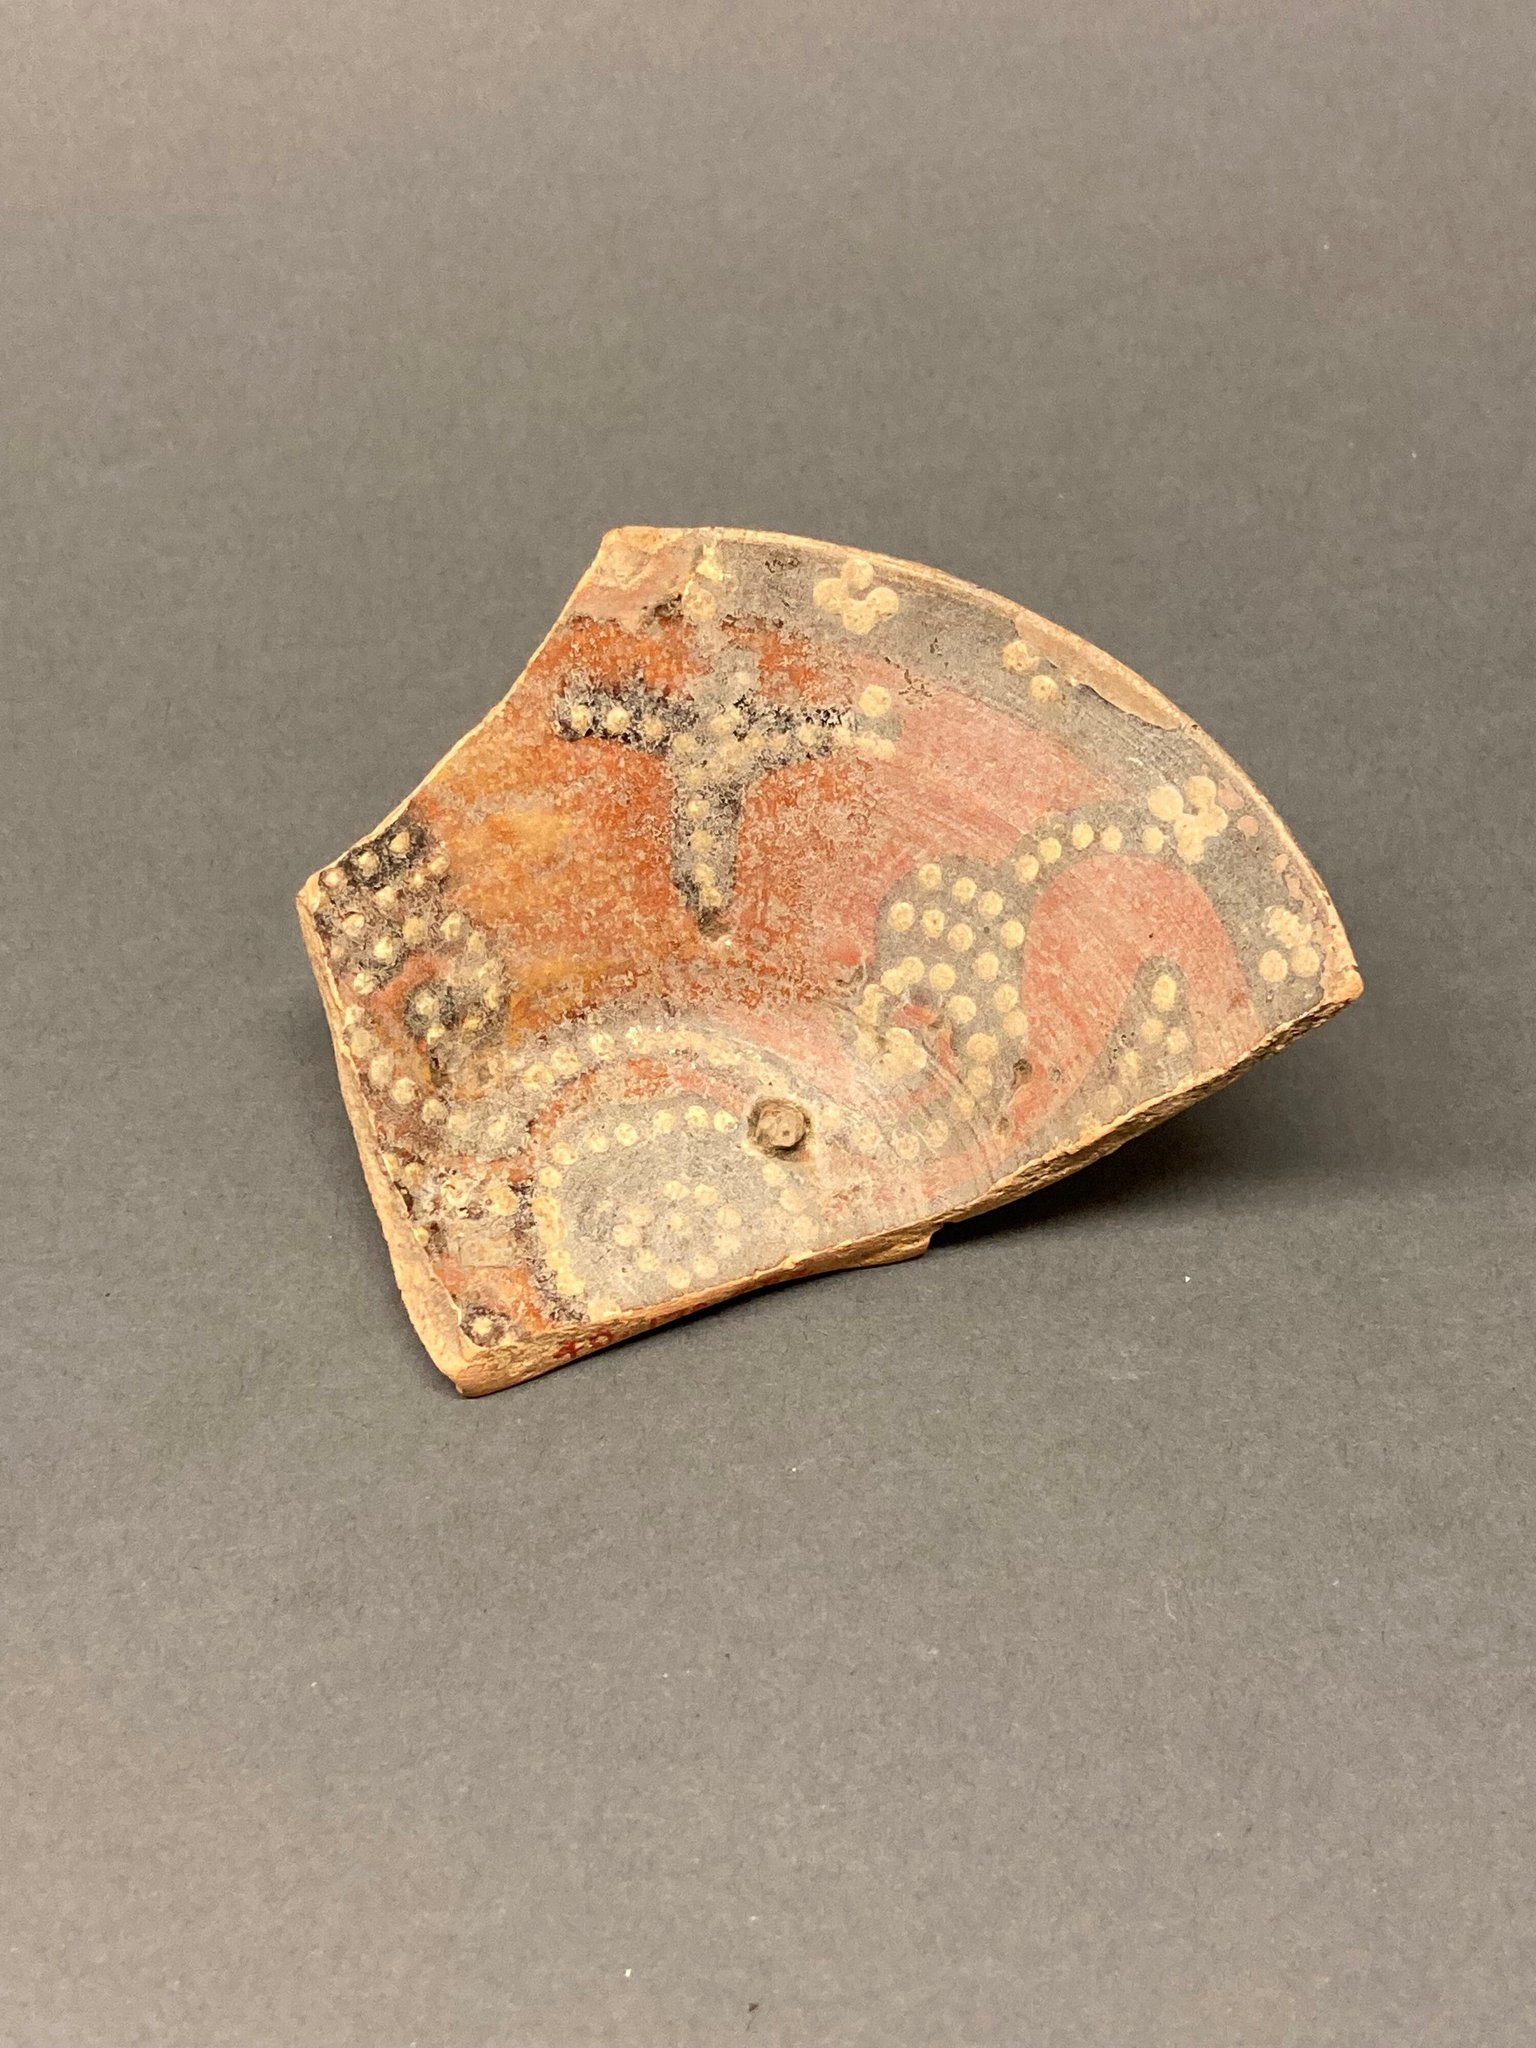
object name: fragment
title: Fragment of a Dish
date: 801-1000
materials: earthenware, glaze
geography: iran